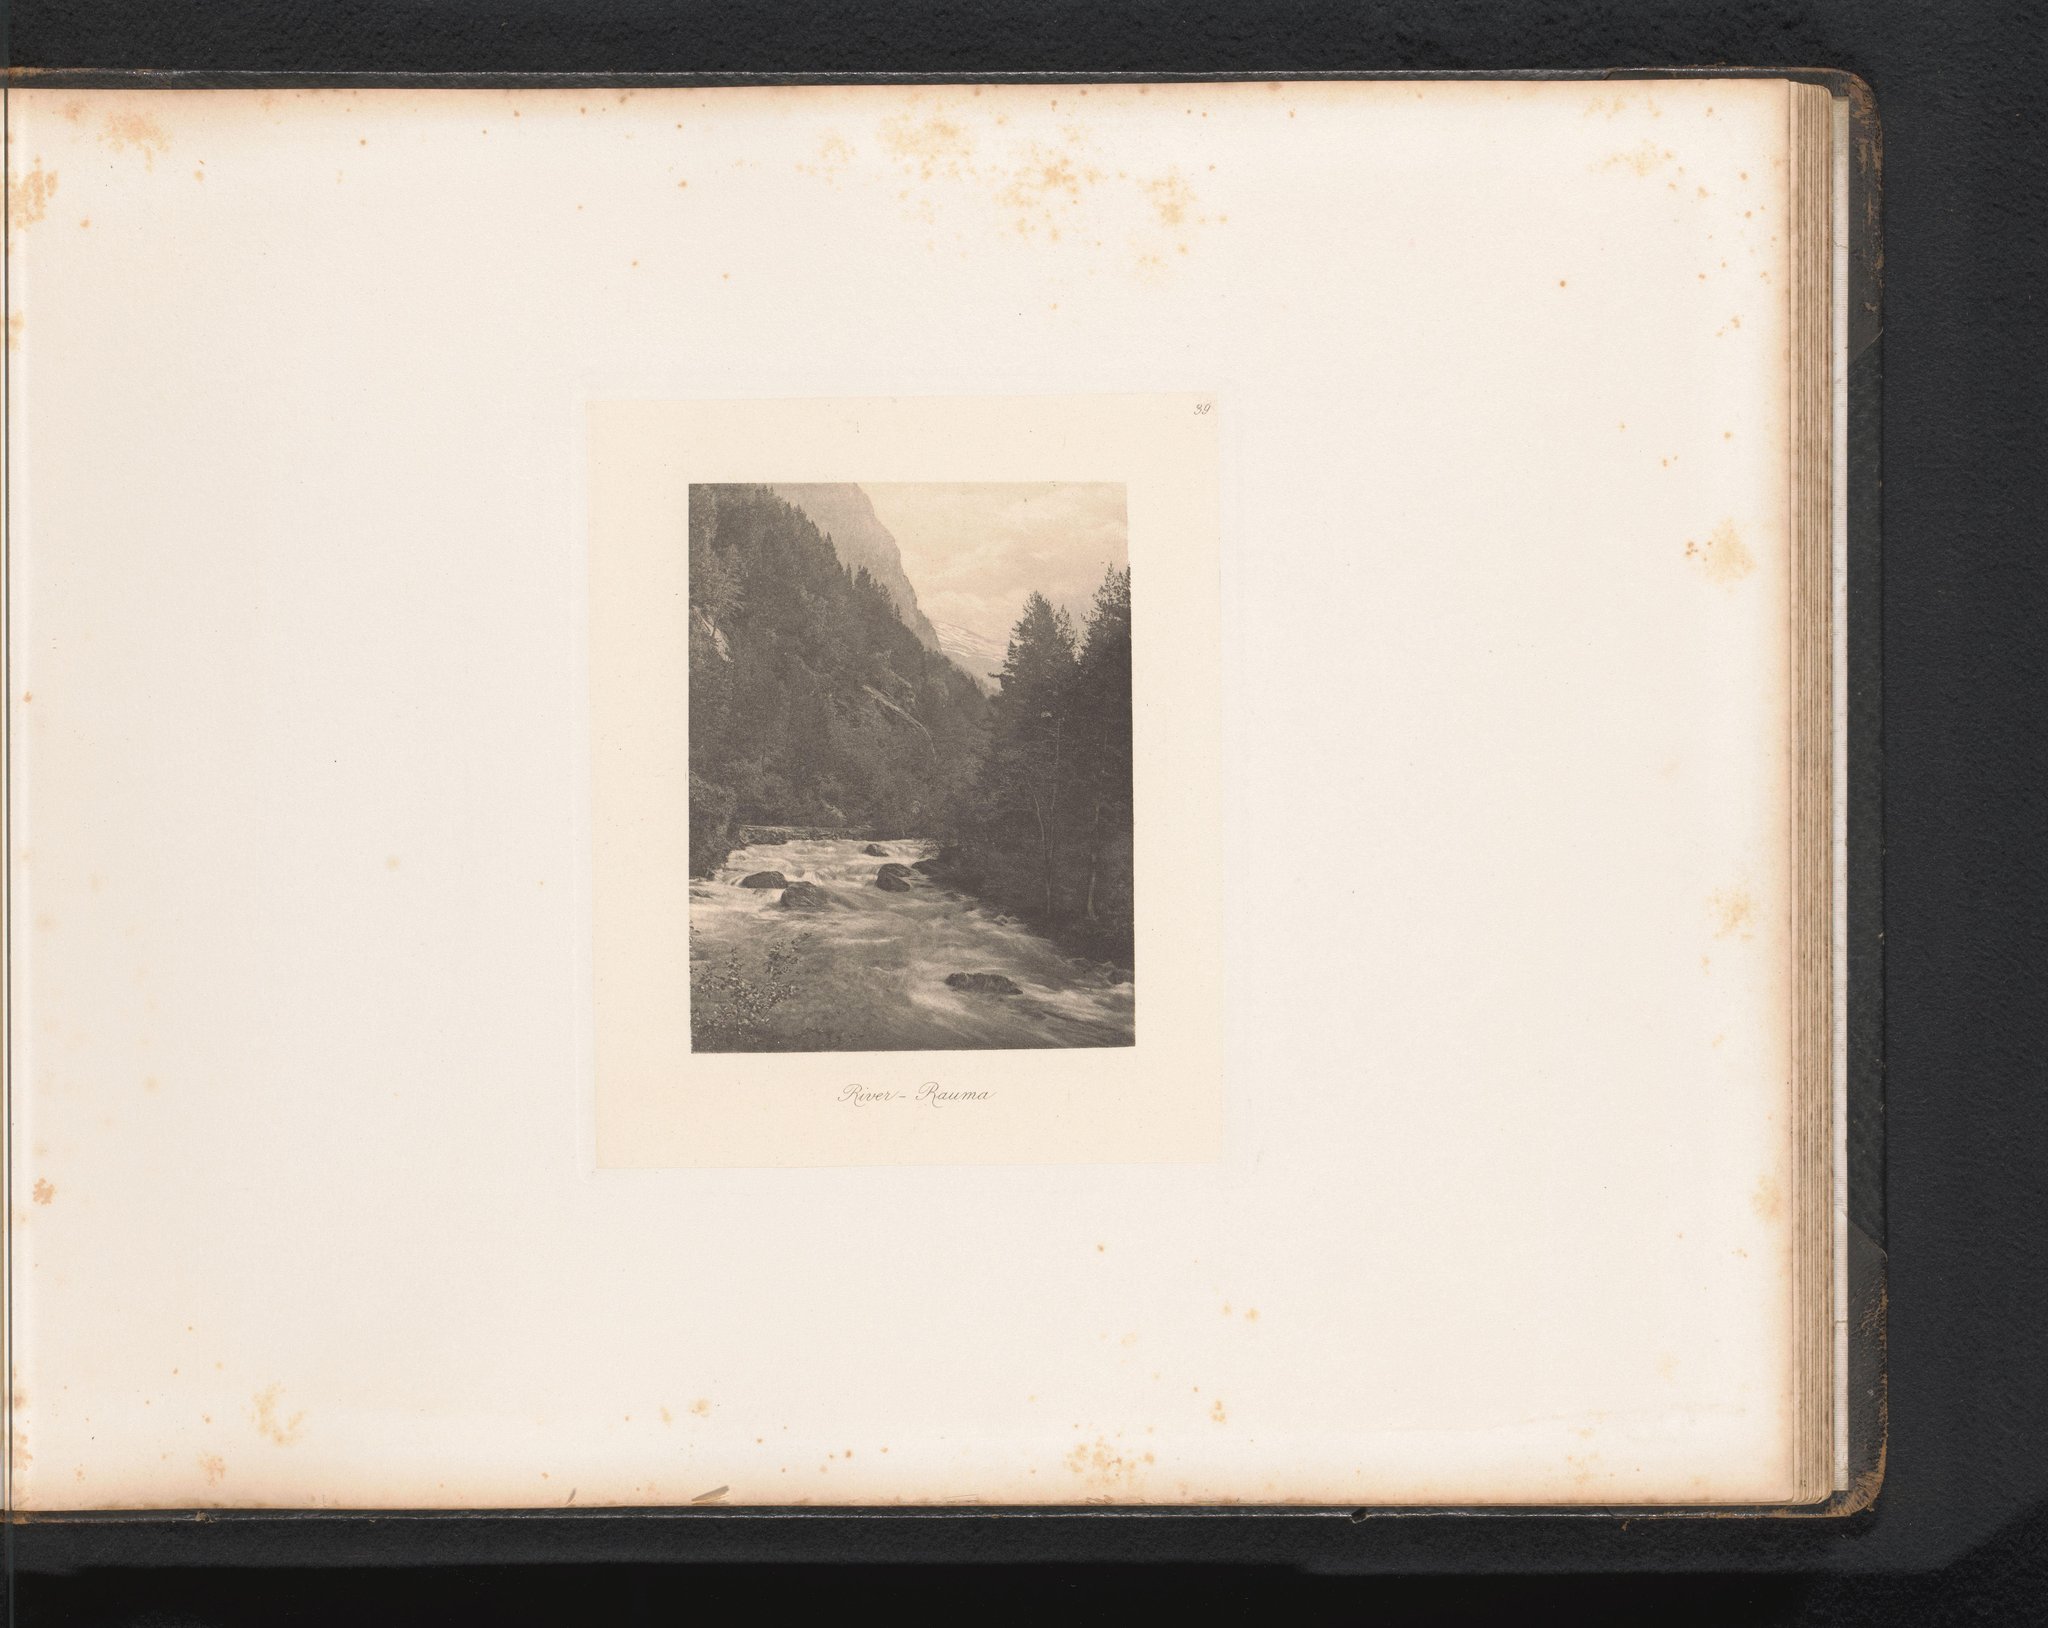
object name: page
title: Gezicht op de Rauma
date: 1888-1893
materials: paper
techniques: photograph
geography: vienna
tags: river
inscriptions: number: ‘39’